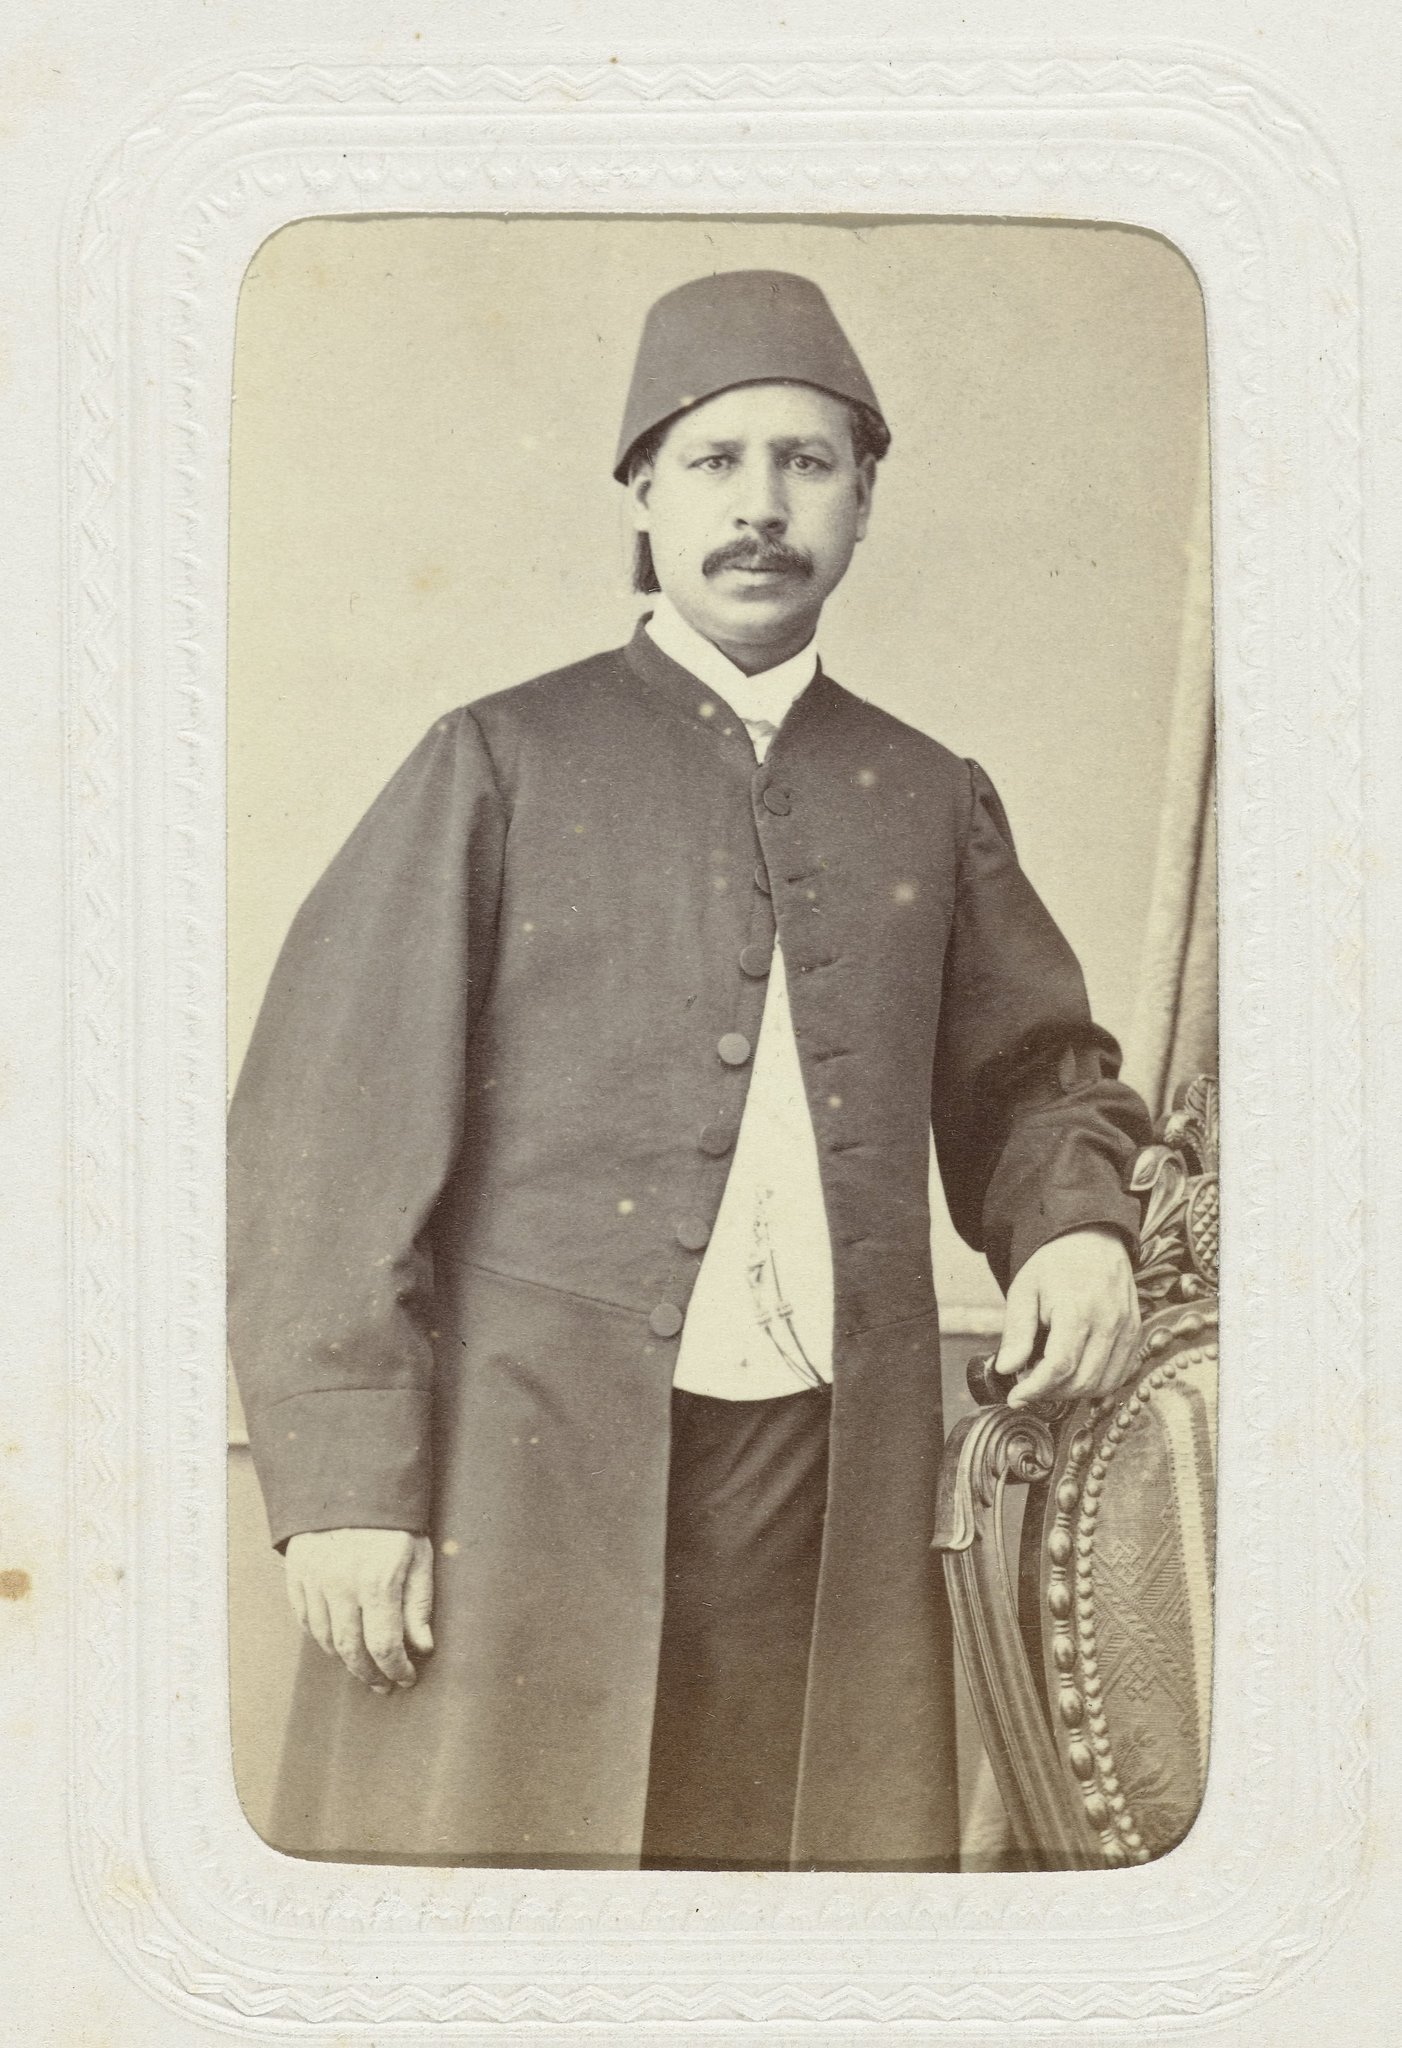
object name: carte de visite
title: Studioportret van een man met snor in lange jas met op zijn hoofd een fez.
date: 1863-1866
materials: cardboard, paper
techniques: albumen print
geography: istanbul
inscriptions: stamp: ‘Abdullah freres Istanbul’